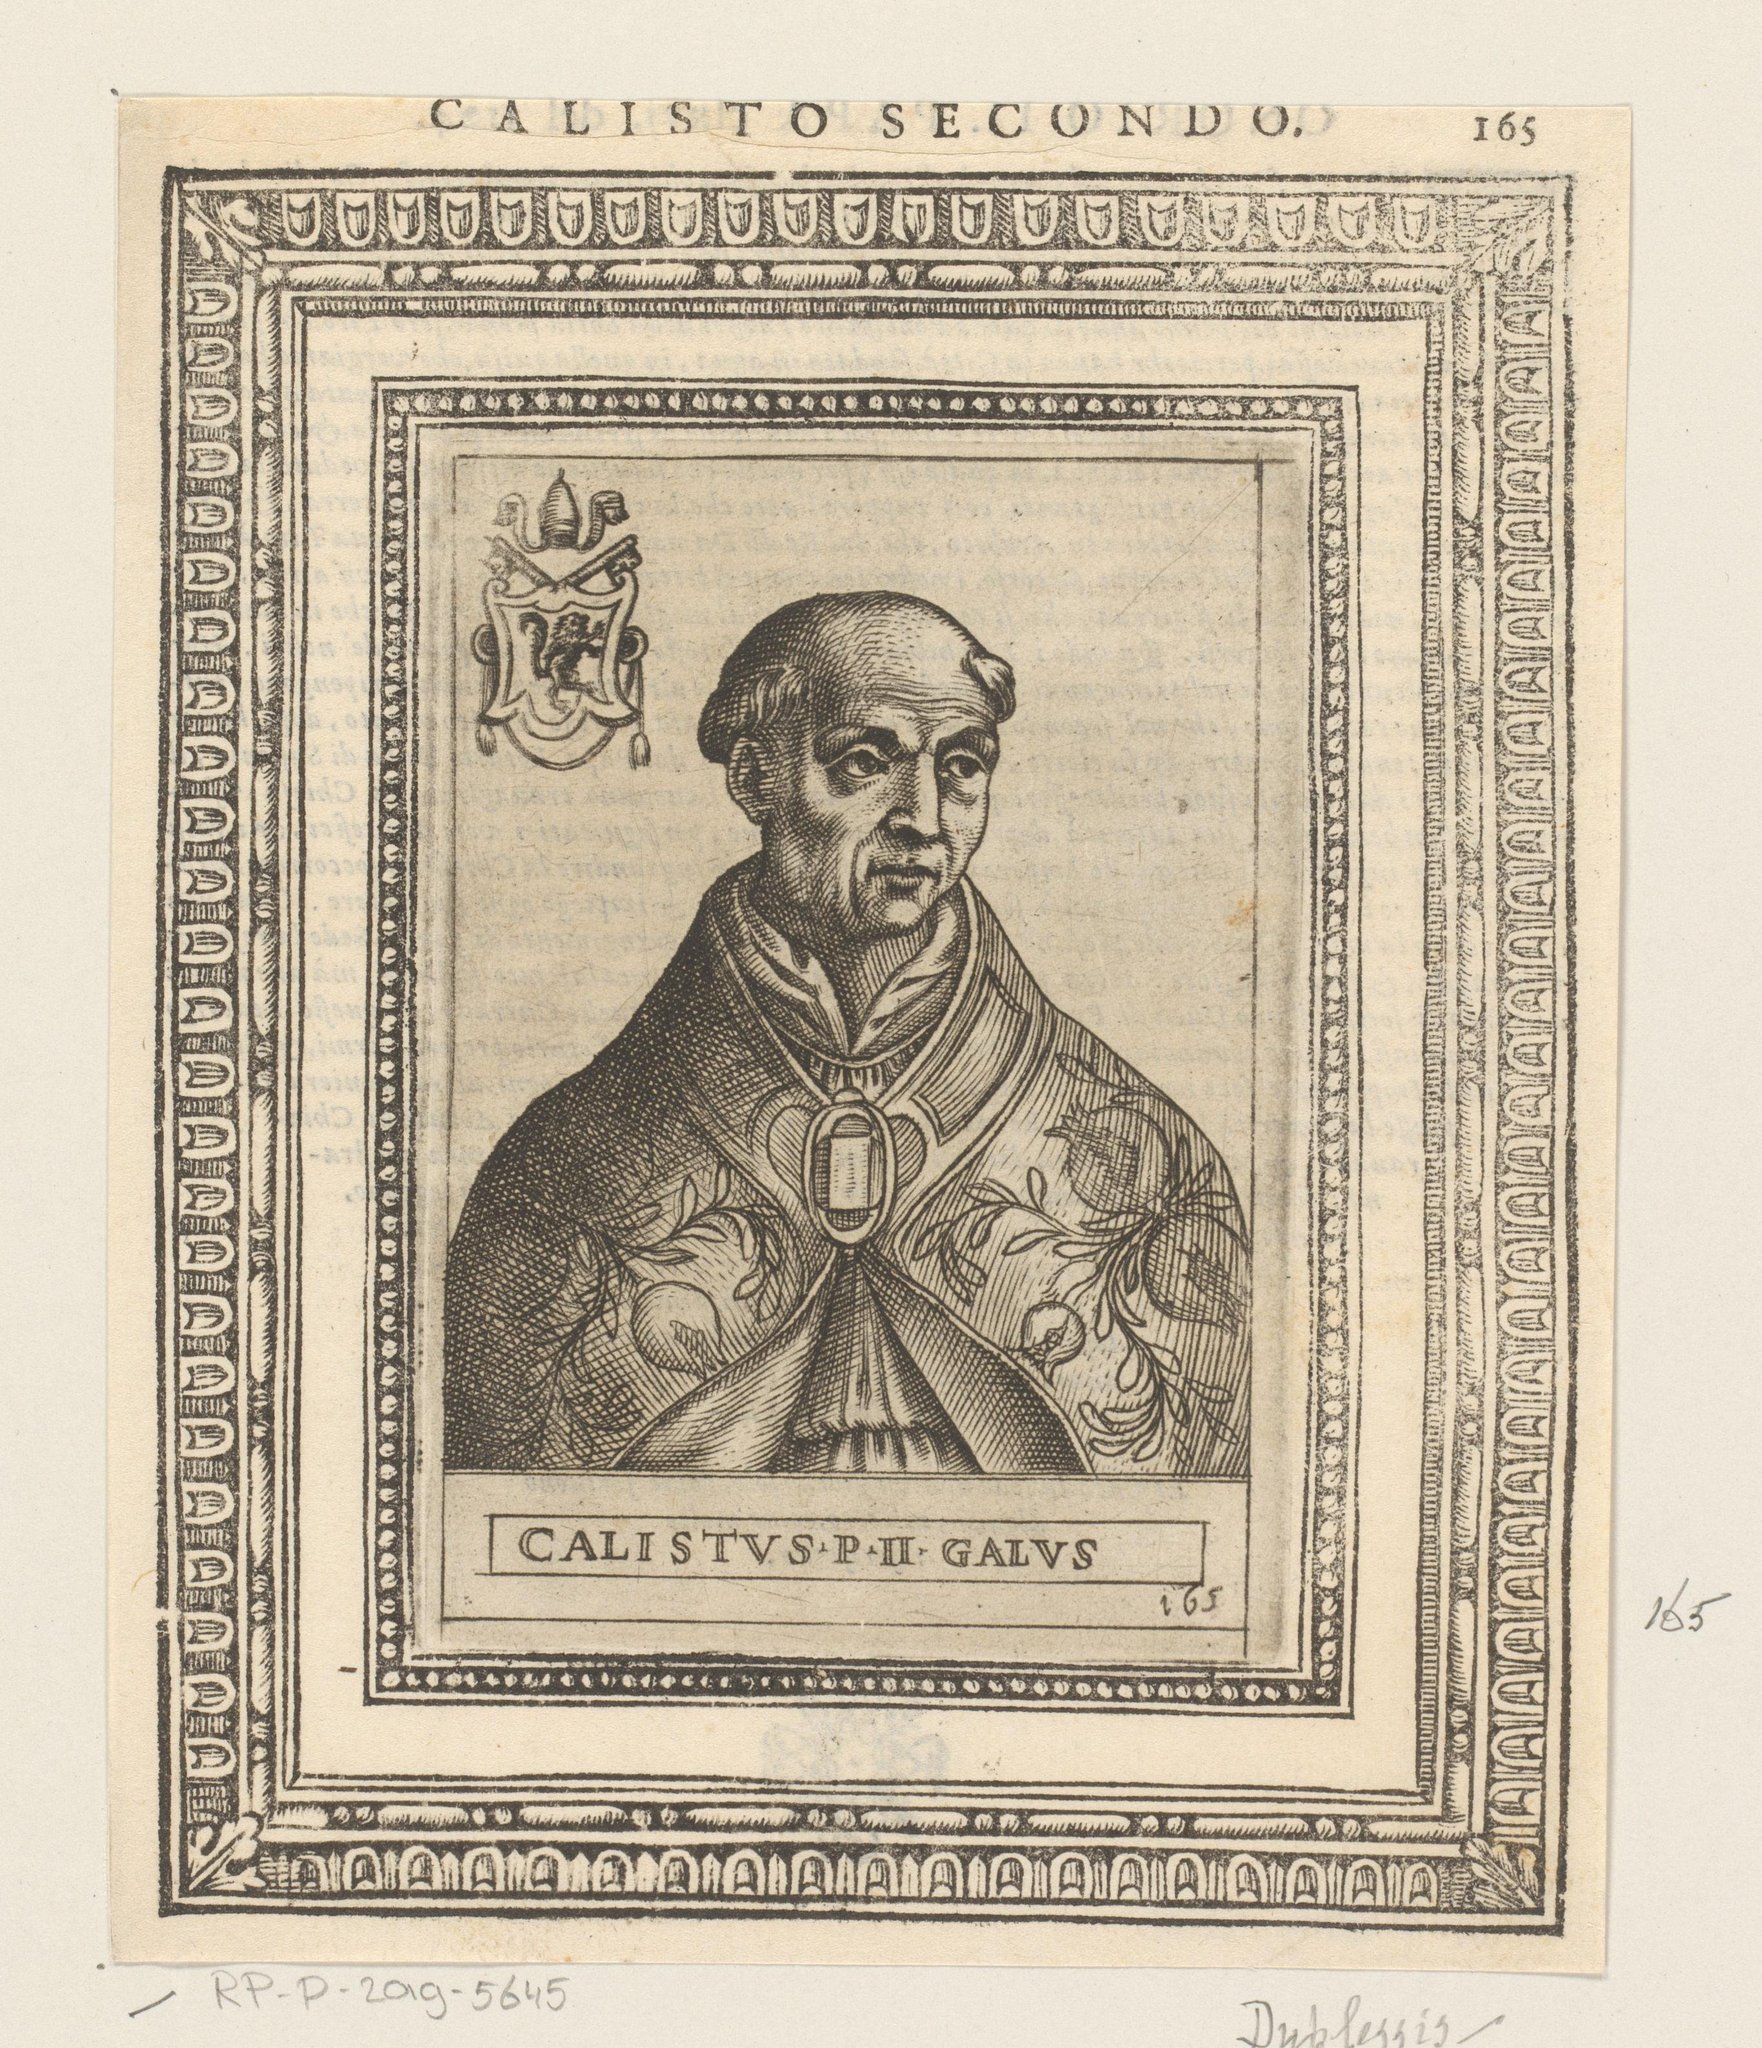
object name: print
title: Calistus P II Galus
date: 1587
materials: paper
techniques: engraving, letterpress printing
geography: rome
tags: historical persons, pope, armorial bearing, heraldry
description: Prent uit: Ciccarelli, Antonio. Le vite de Pontefici di Antonio Ciccarelli (...). Rome: Domenico Basa, 1587. Prent voor het eerst verschenen in: Cavalieri, Giovanni Battista de'. Pontificum romanorum effigies (...). Rome: Domenico Basa en Francesco Zanetti, 1580. Prent ook gebruikt in latere publicaties.